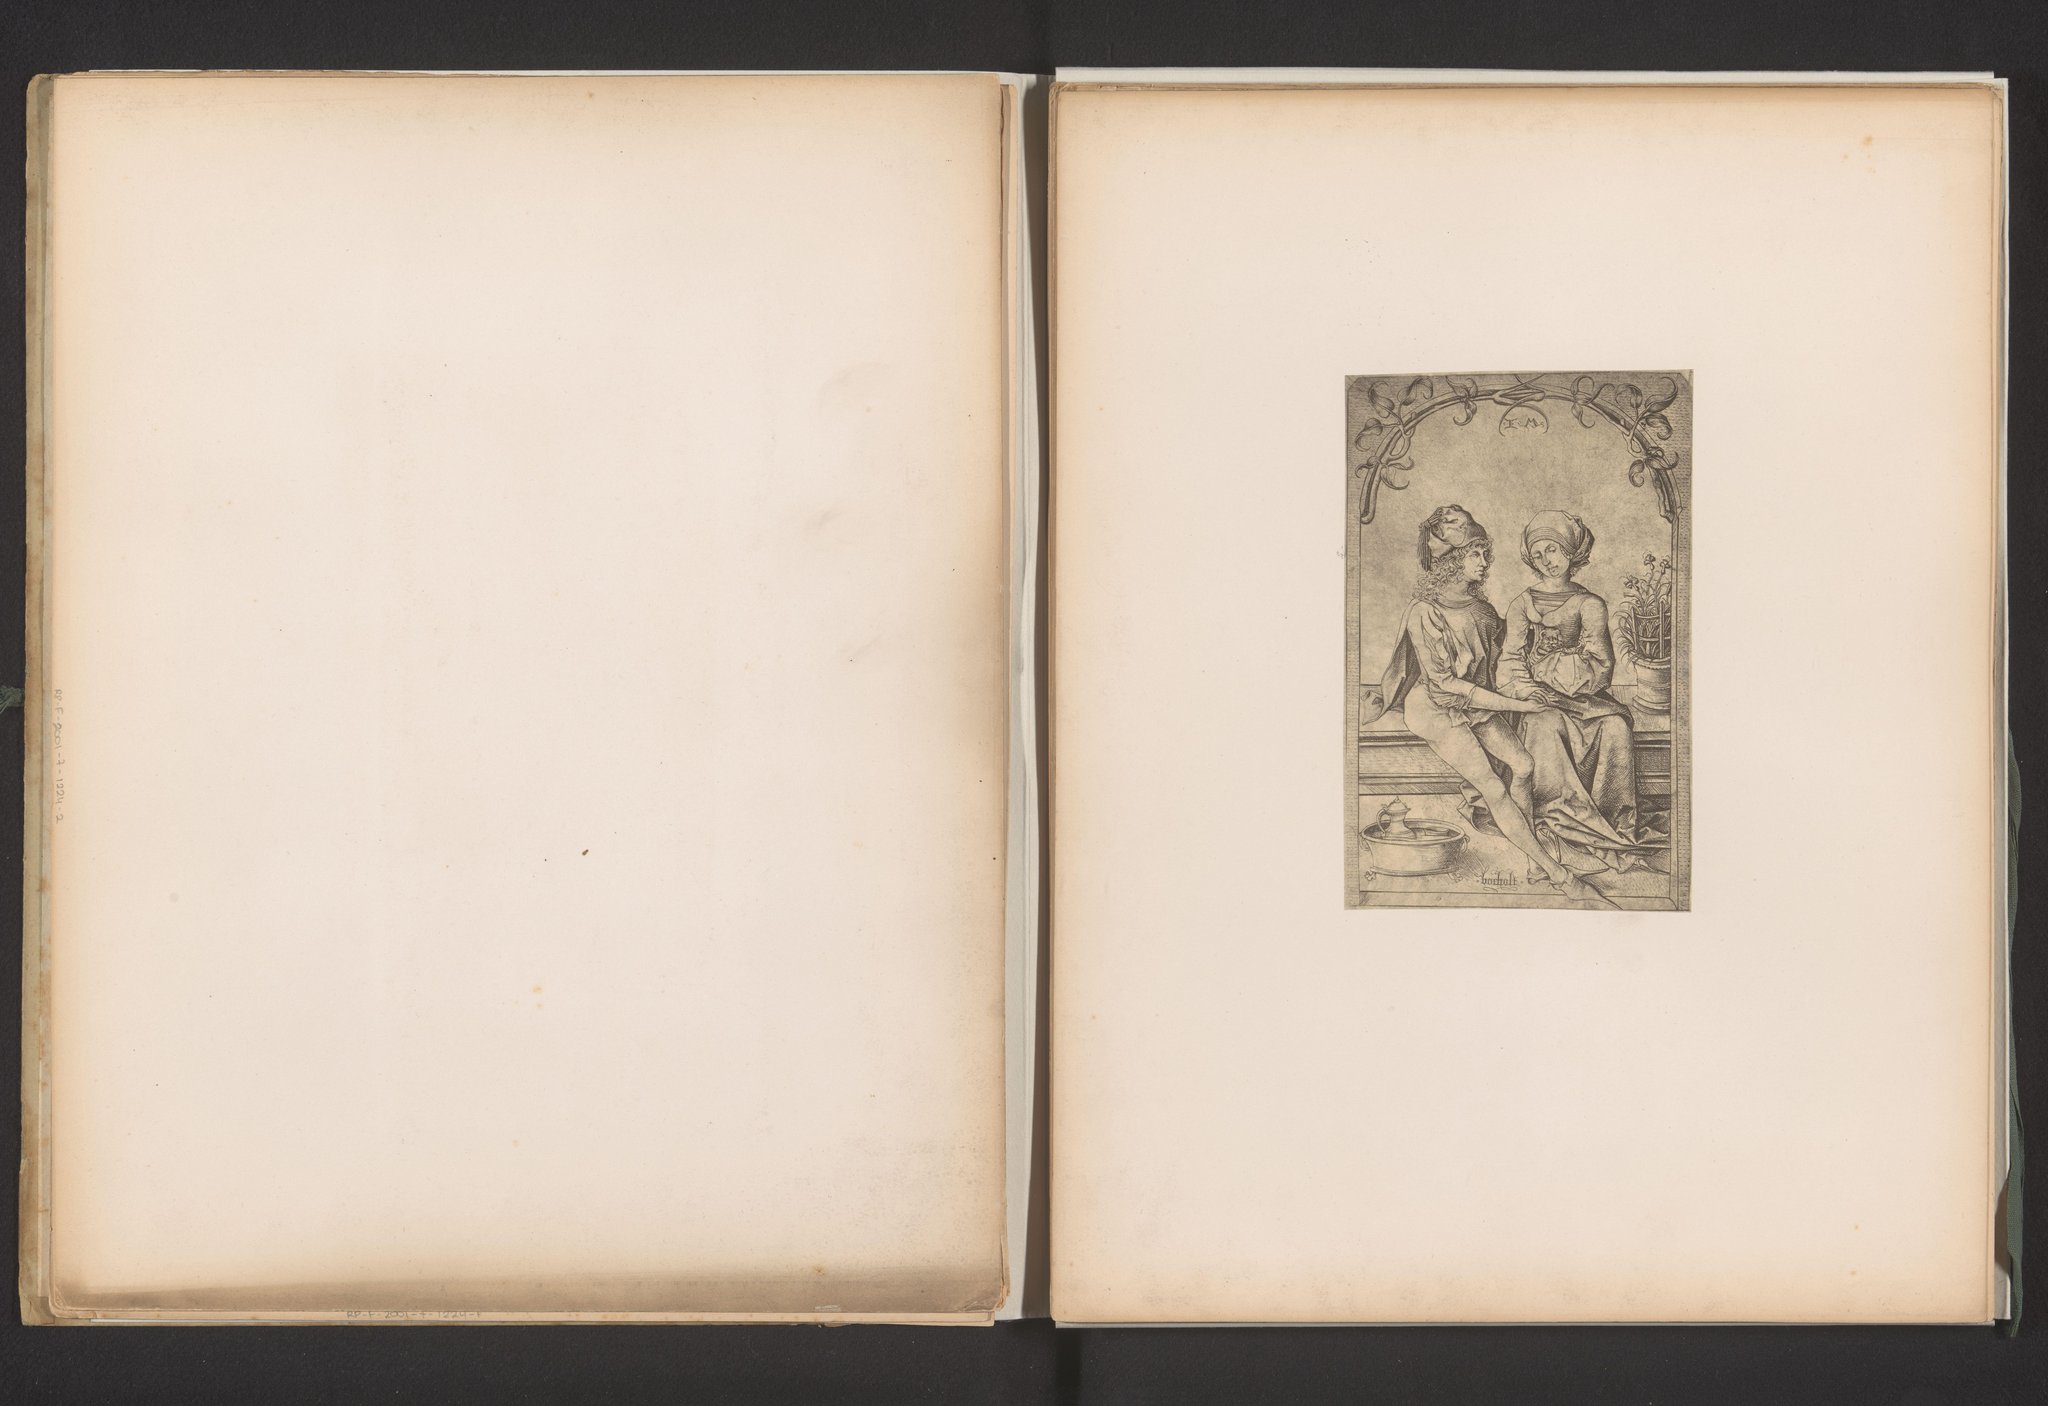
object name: photomechanical print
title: Reproductie van een prent van een jong paar door Israhel van Meckenem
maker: israhel van meckenem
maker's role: print maker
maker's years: 1440-1517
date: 1867-1872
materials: paper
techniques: woodburytype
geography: brussels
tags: arm in arm (lovers)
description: Deze prent maakt deel uit van een omslag met 12 prenten op 12 bladen.